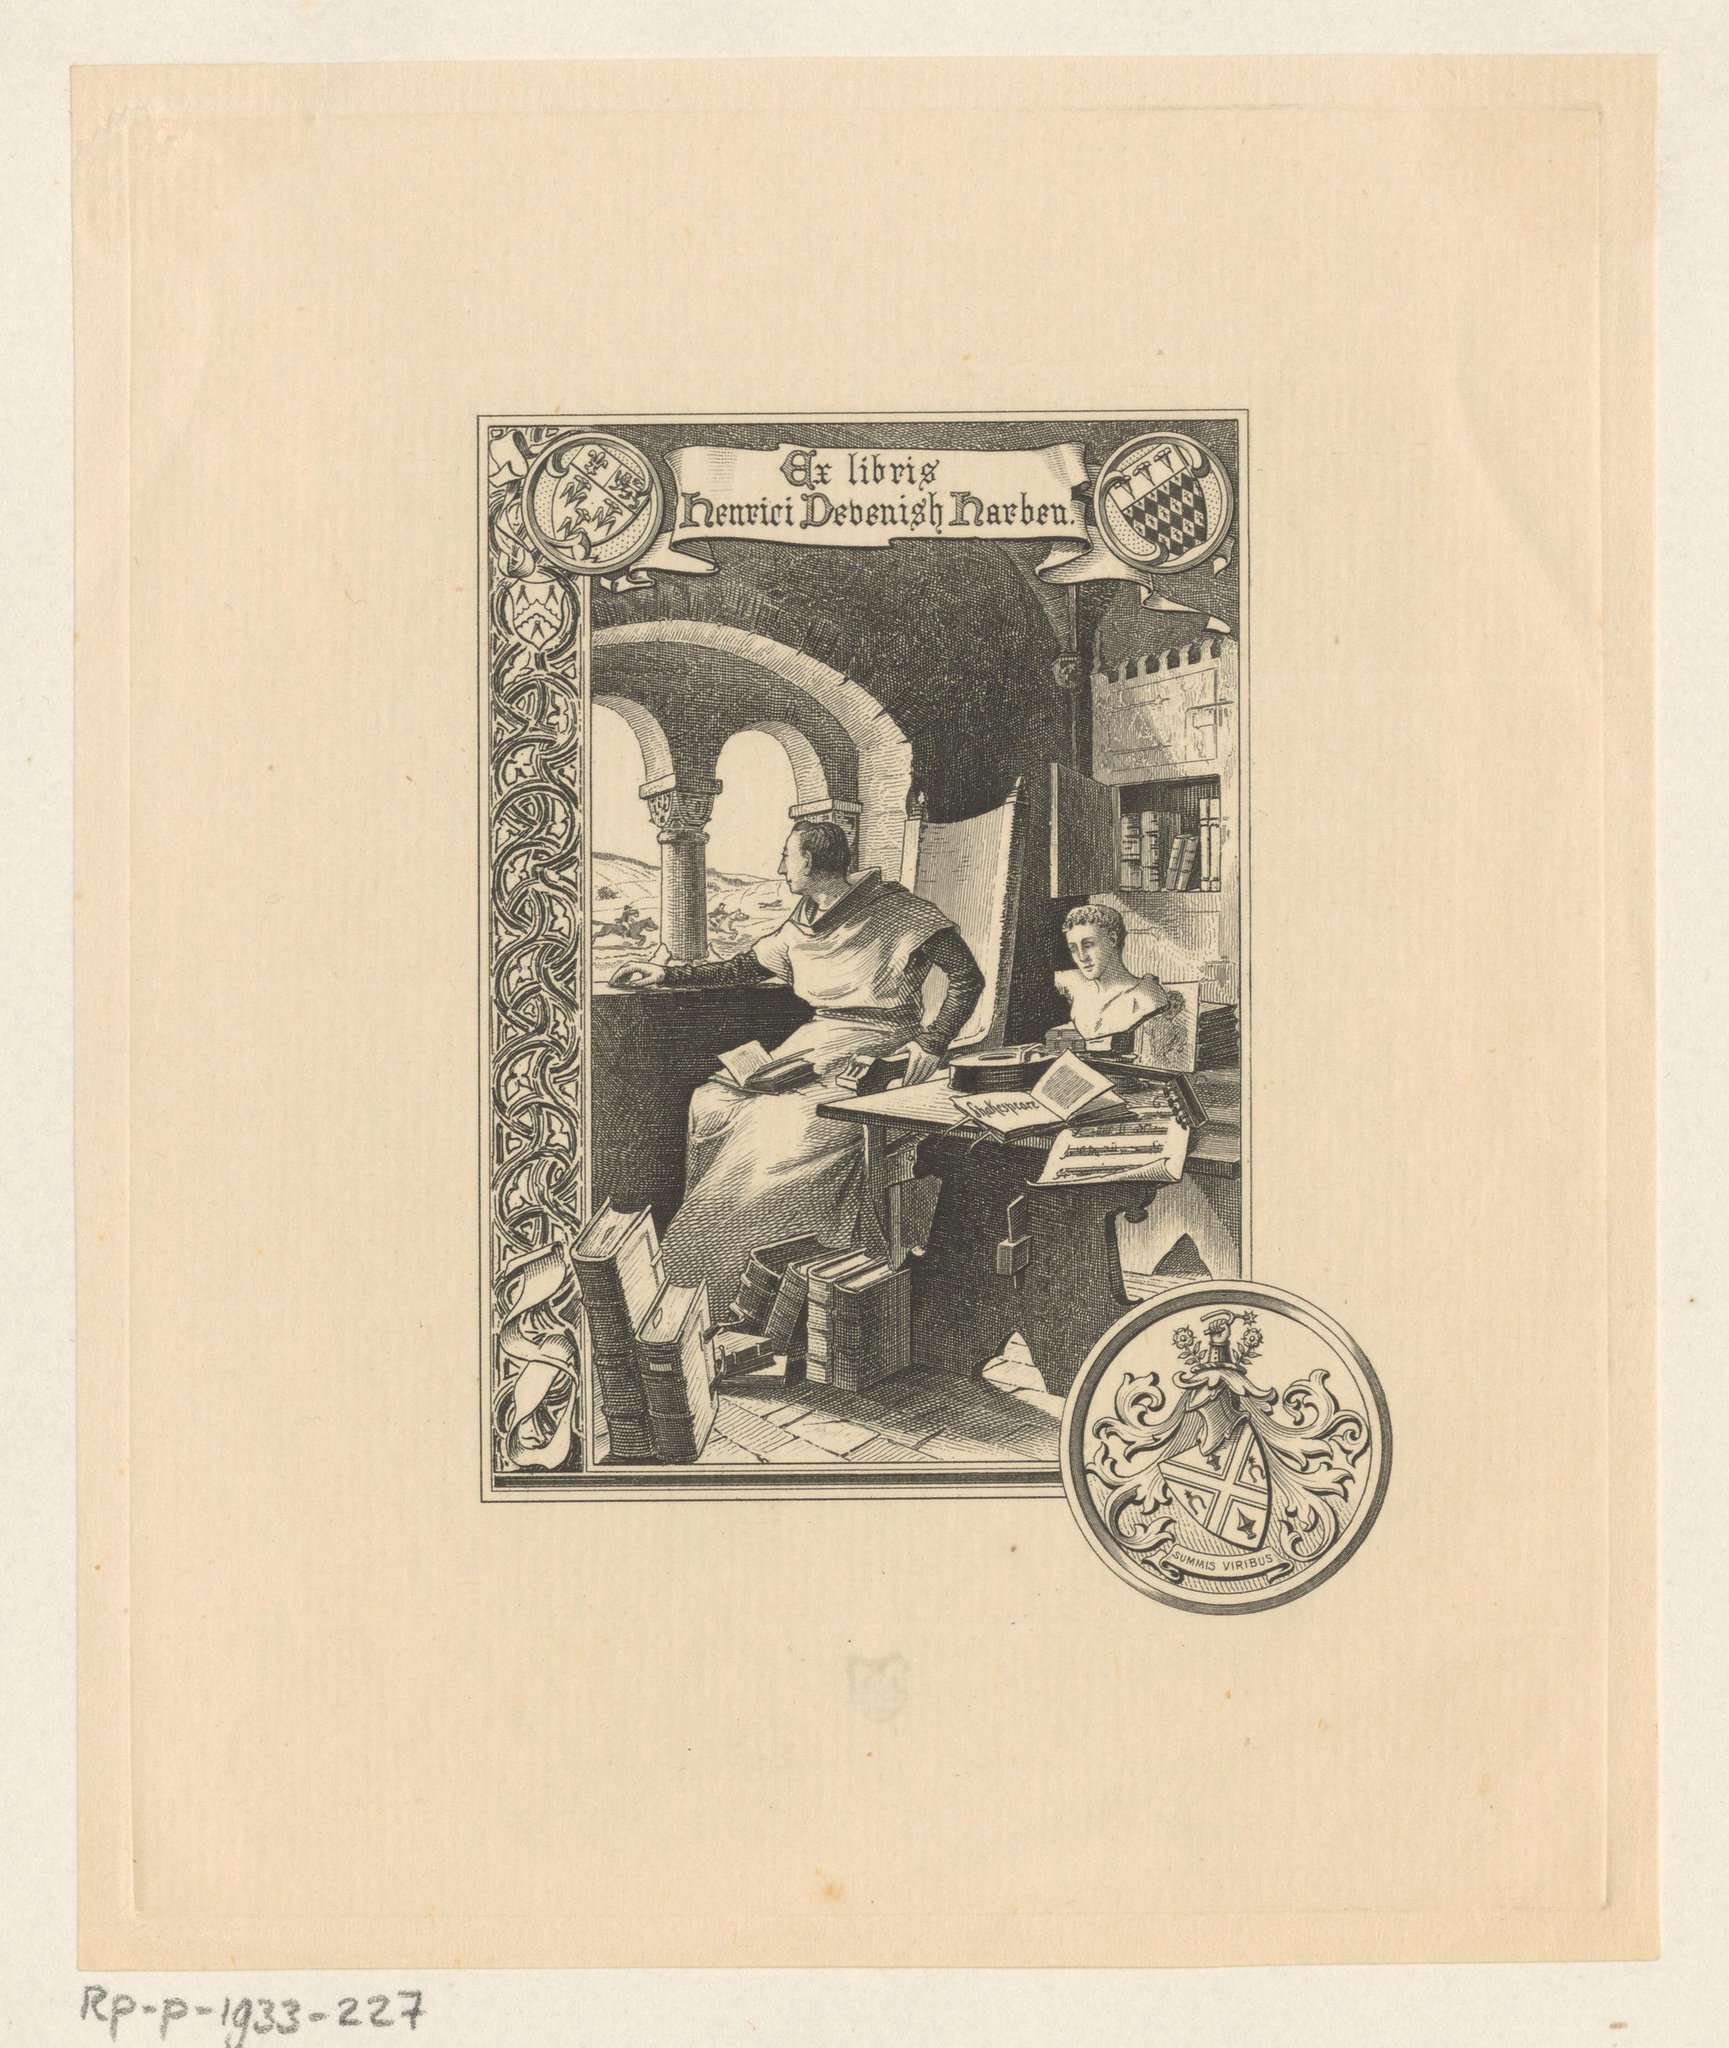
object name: bookplate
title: Ex libris van Henrici Debenish Harben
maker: henry james haley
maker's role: painter, print maker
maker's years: 1874-1934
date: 1884-1933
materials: paper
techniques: etching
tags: politician, study; 'studiolo'; library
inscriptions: collector's mark: Lugt 2760